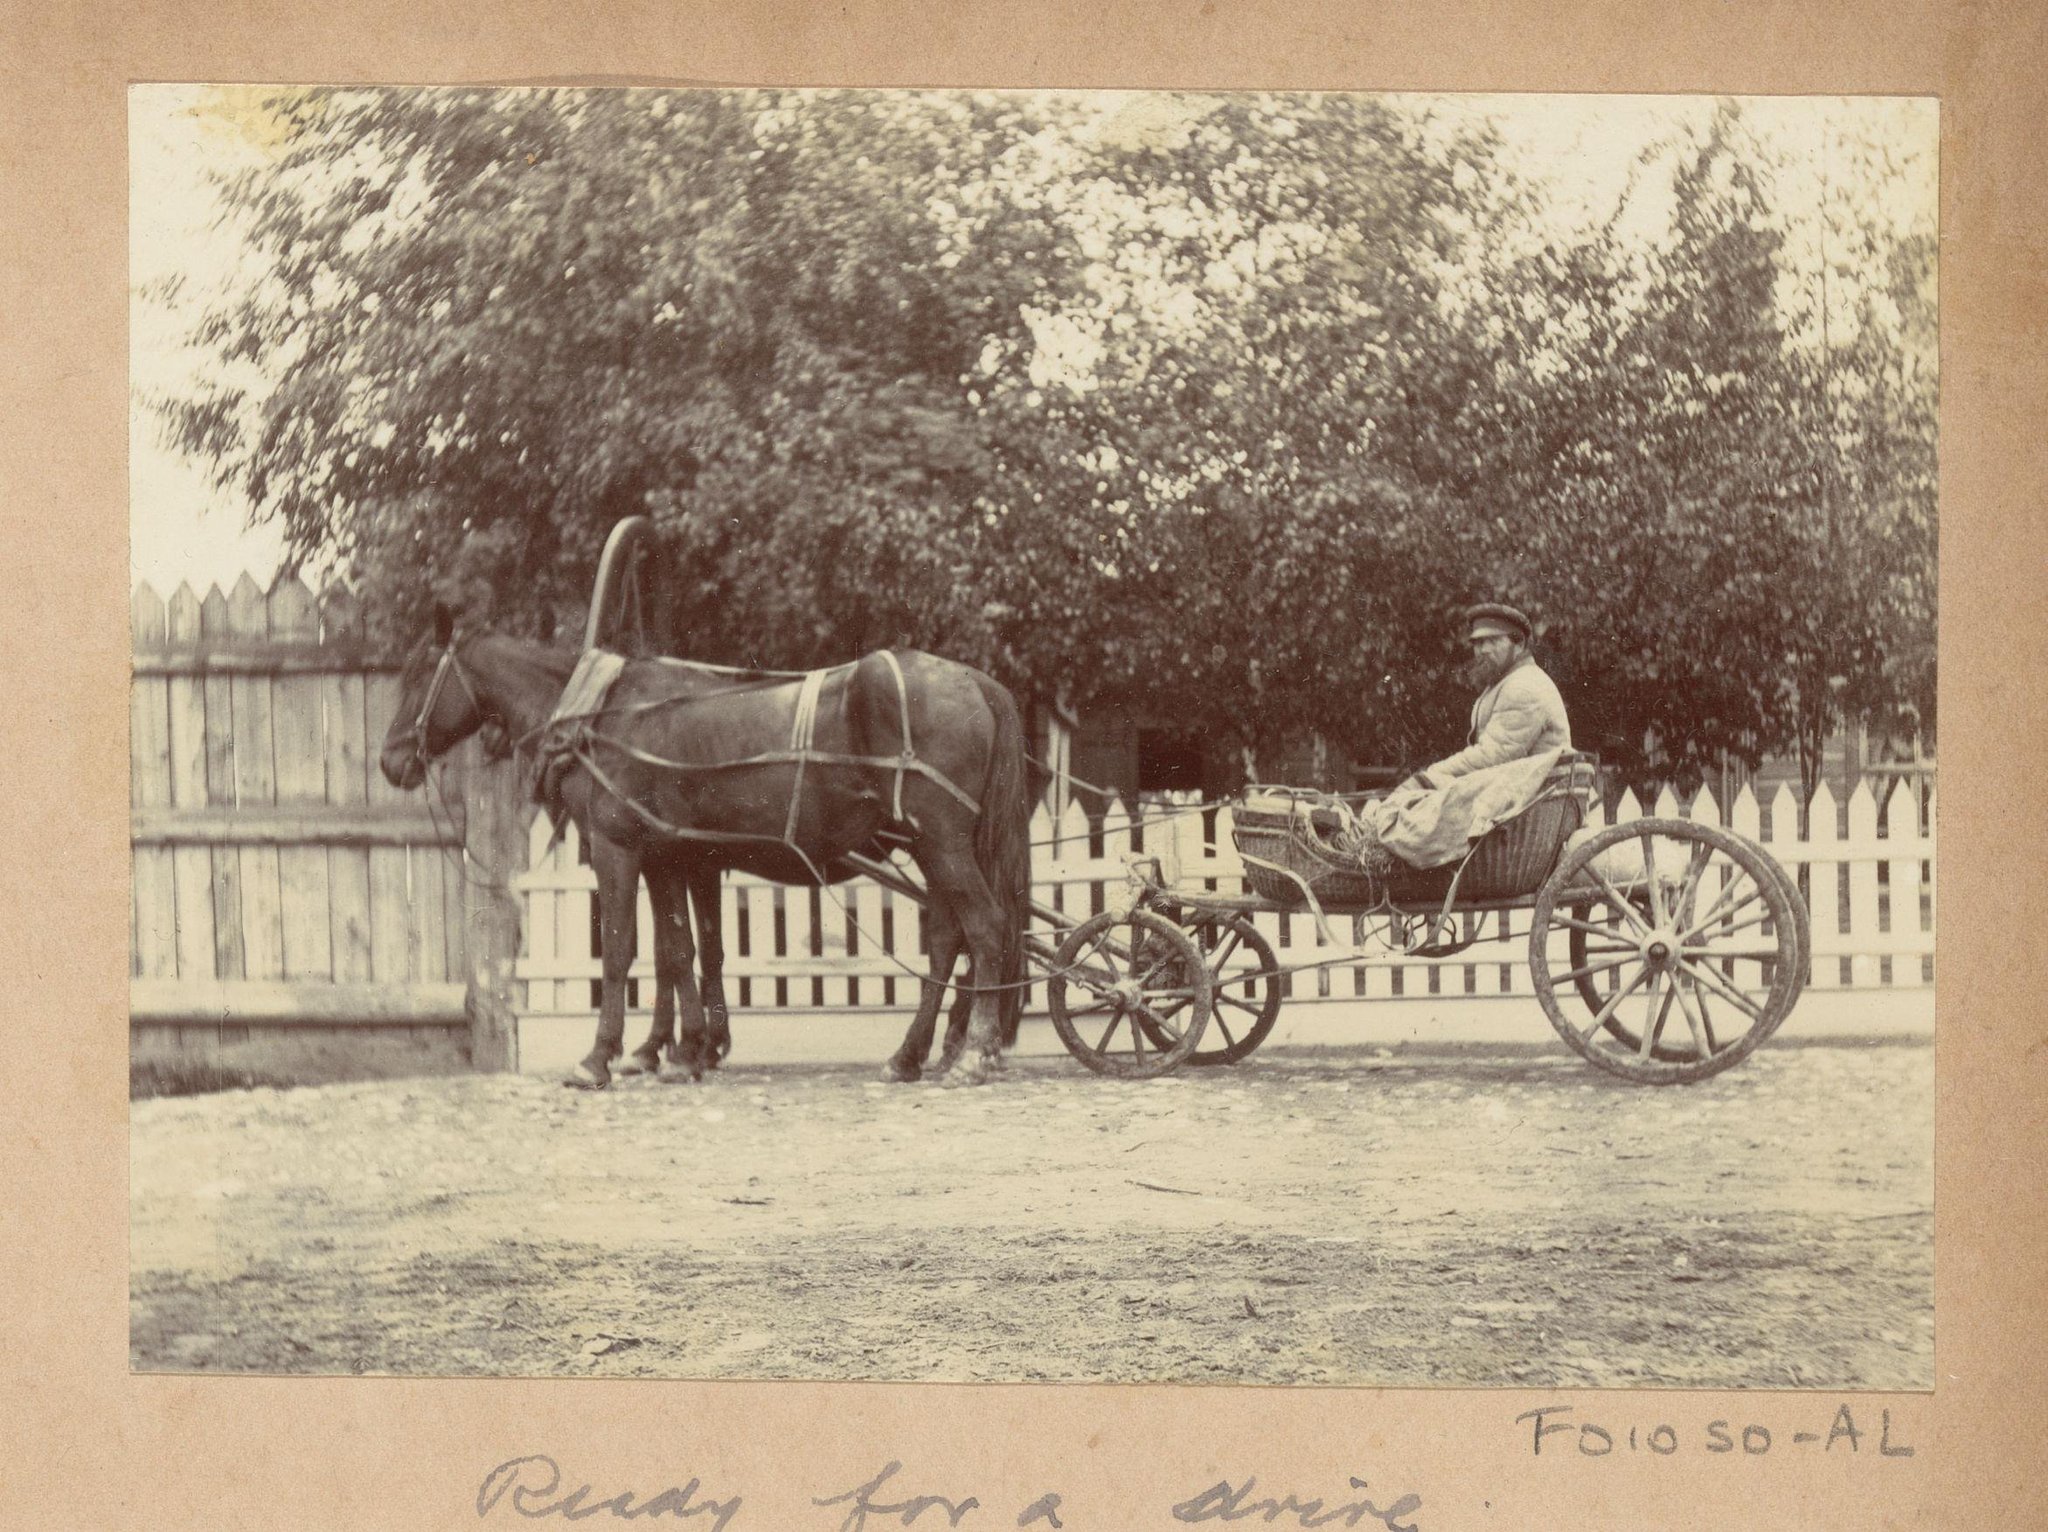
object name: photograph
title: Man met paard en wagen in Rusland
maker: joseph cheetham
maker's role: engineer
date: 1903-1904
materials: photographic support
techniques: gelatin silver print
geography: russia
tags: four-wheeled, animal-drawn vehicle, e.g.: cab, carriage, coach (+ conveyance for transport of persons), russia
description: Onderdeel van Fotoalbum van de Engelse familie Cheetham met opnames van hun verblijf in Rusland.